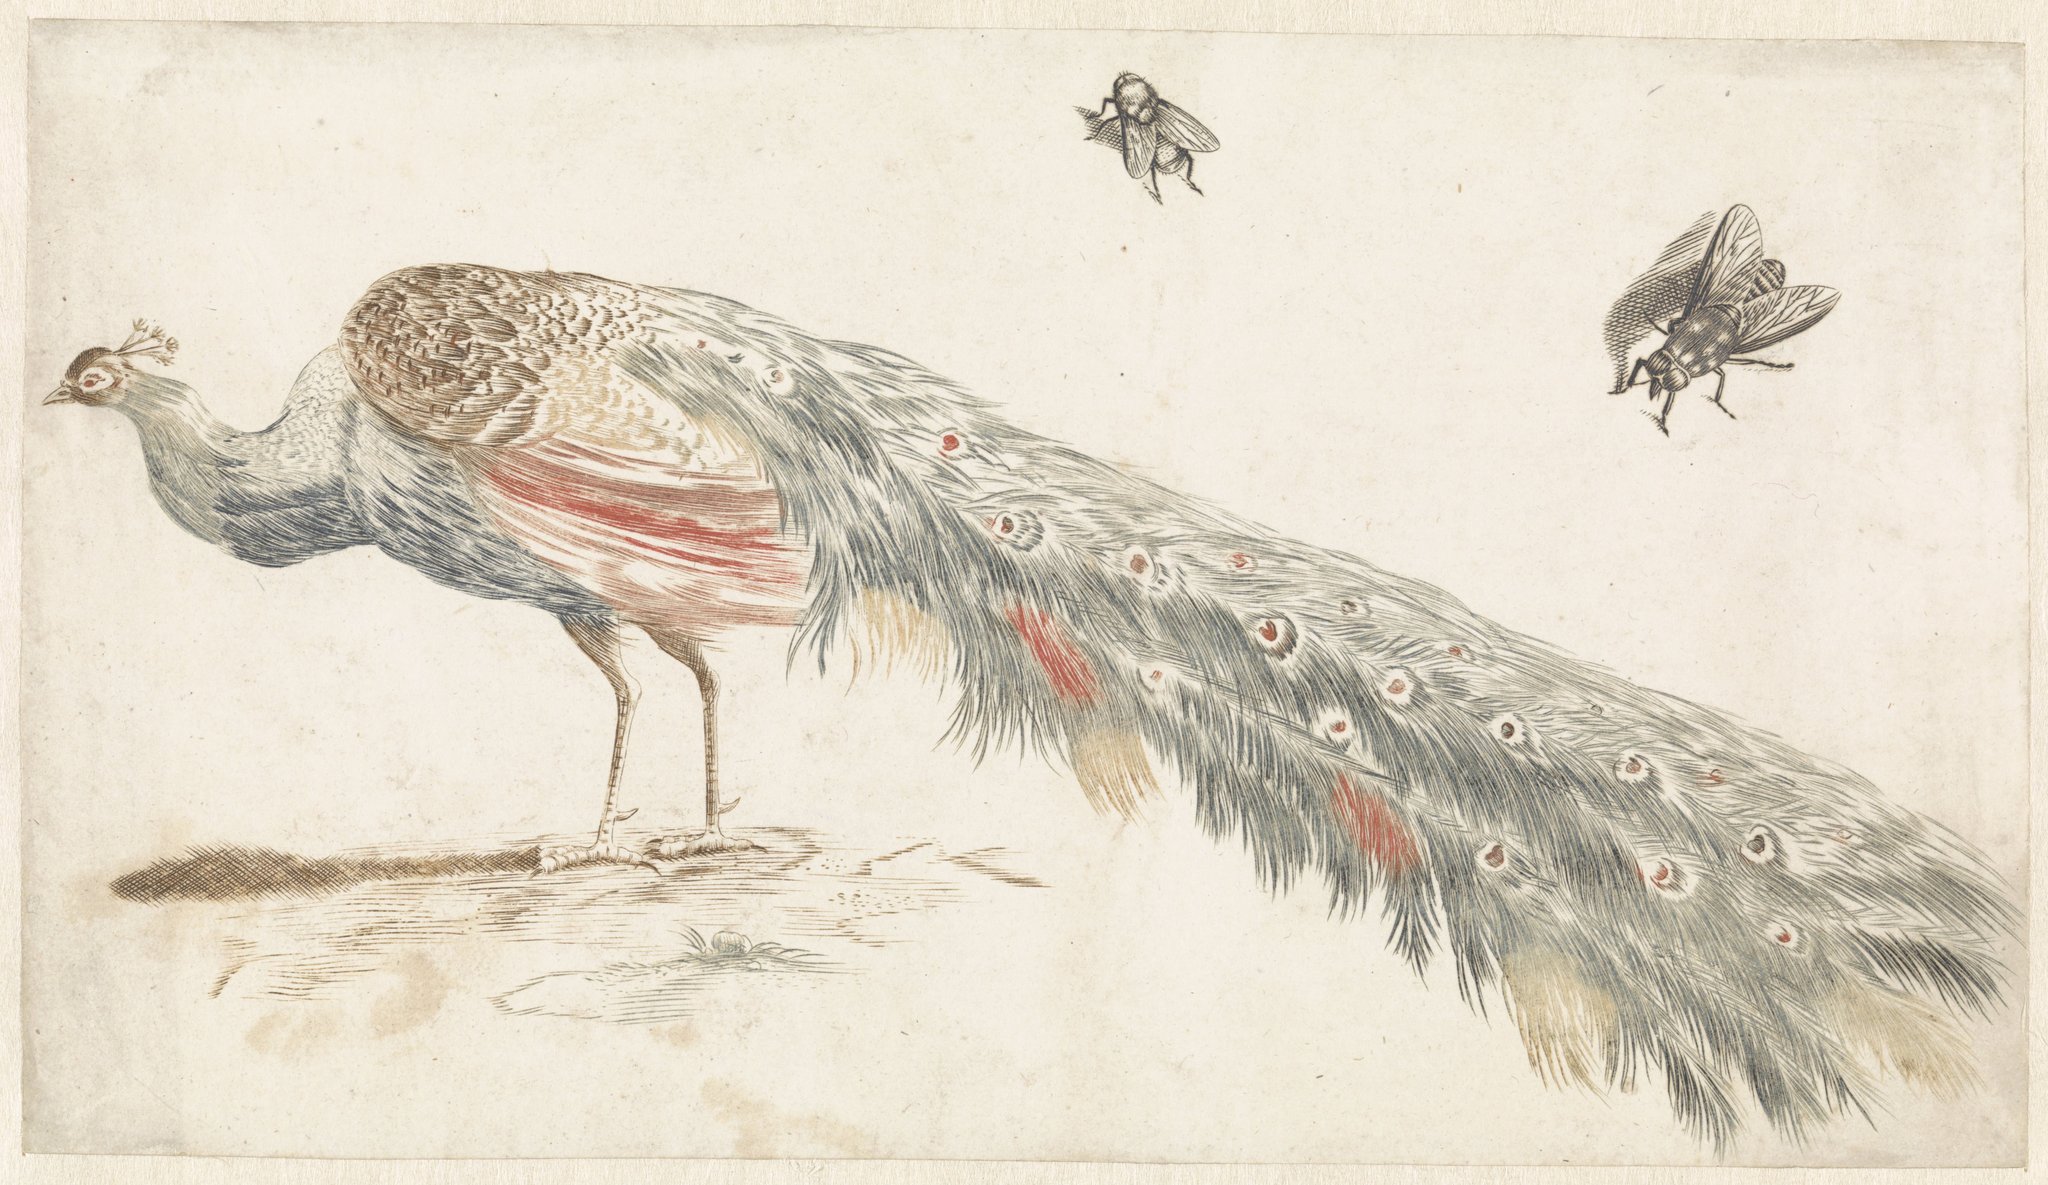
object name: print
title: Pauw en twee vliegen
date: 1688-1698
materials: paper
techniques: printing, engraving, lithography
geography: netherlands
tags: ornamental birds: peacock, insects: fly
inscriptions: collector's mark: Lugt 2228